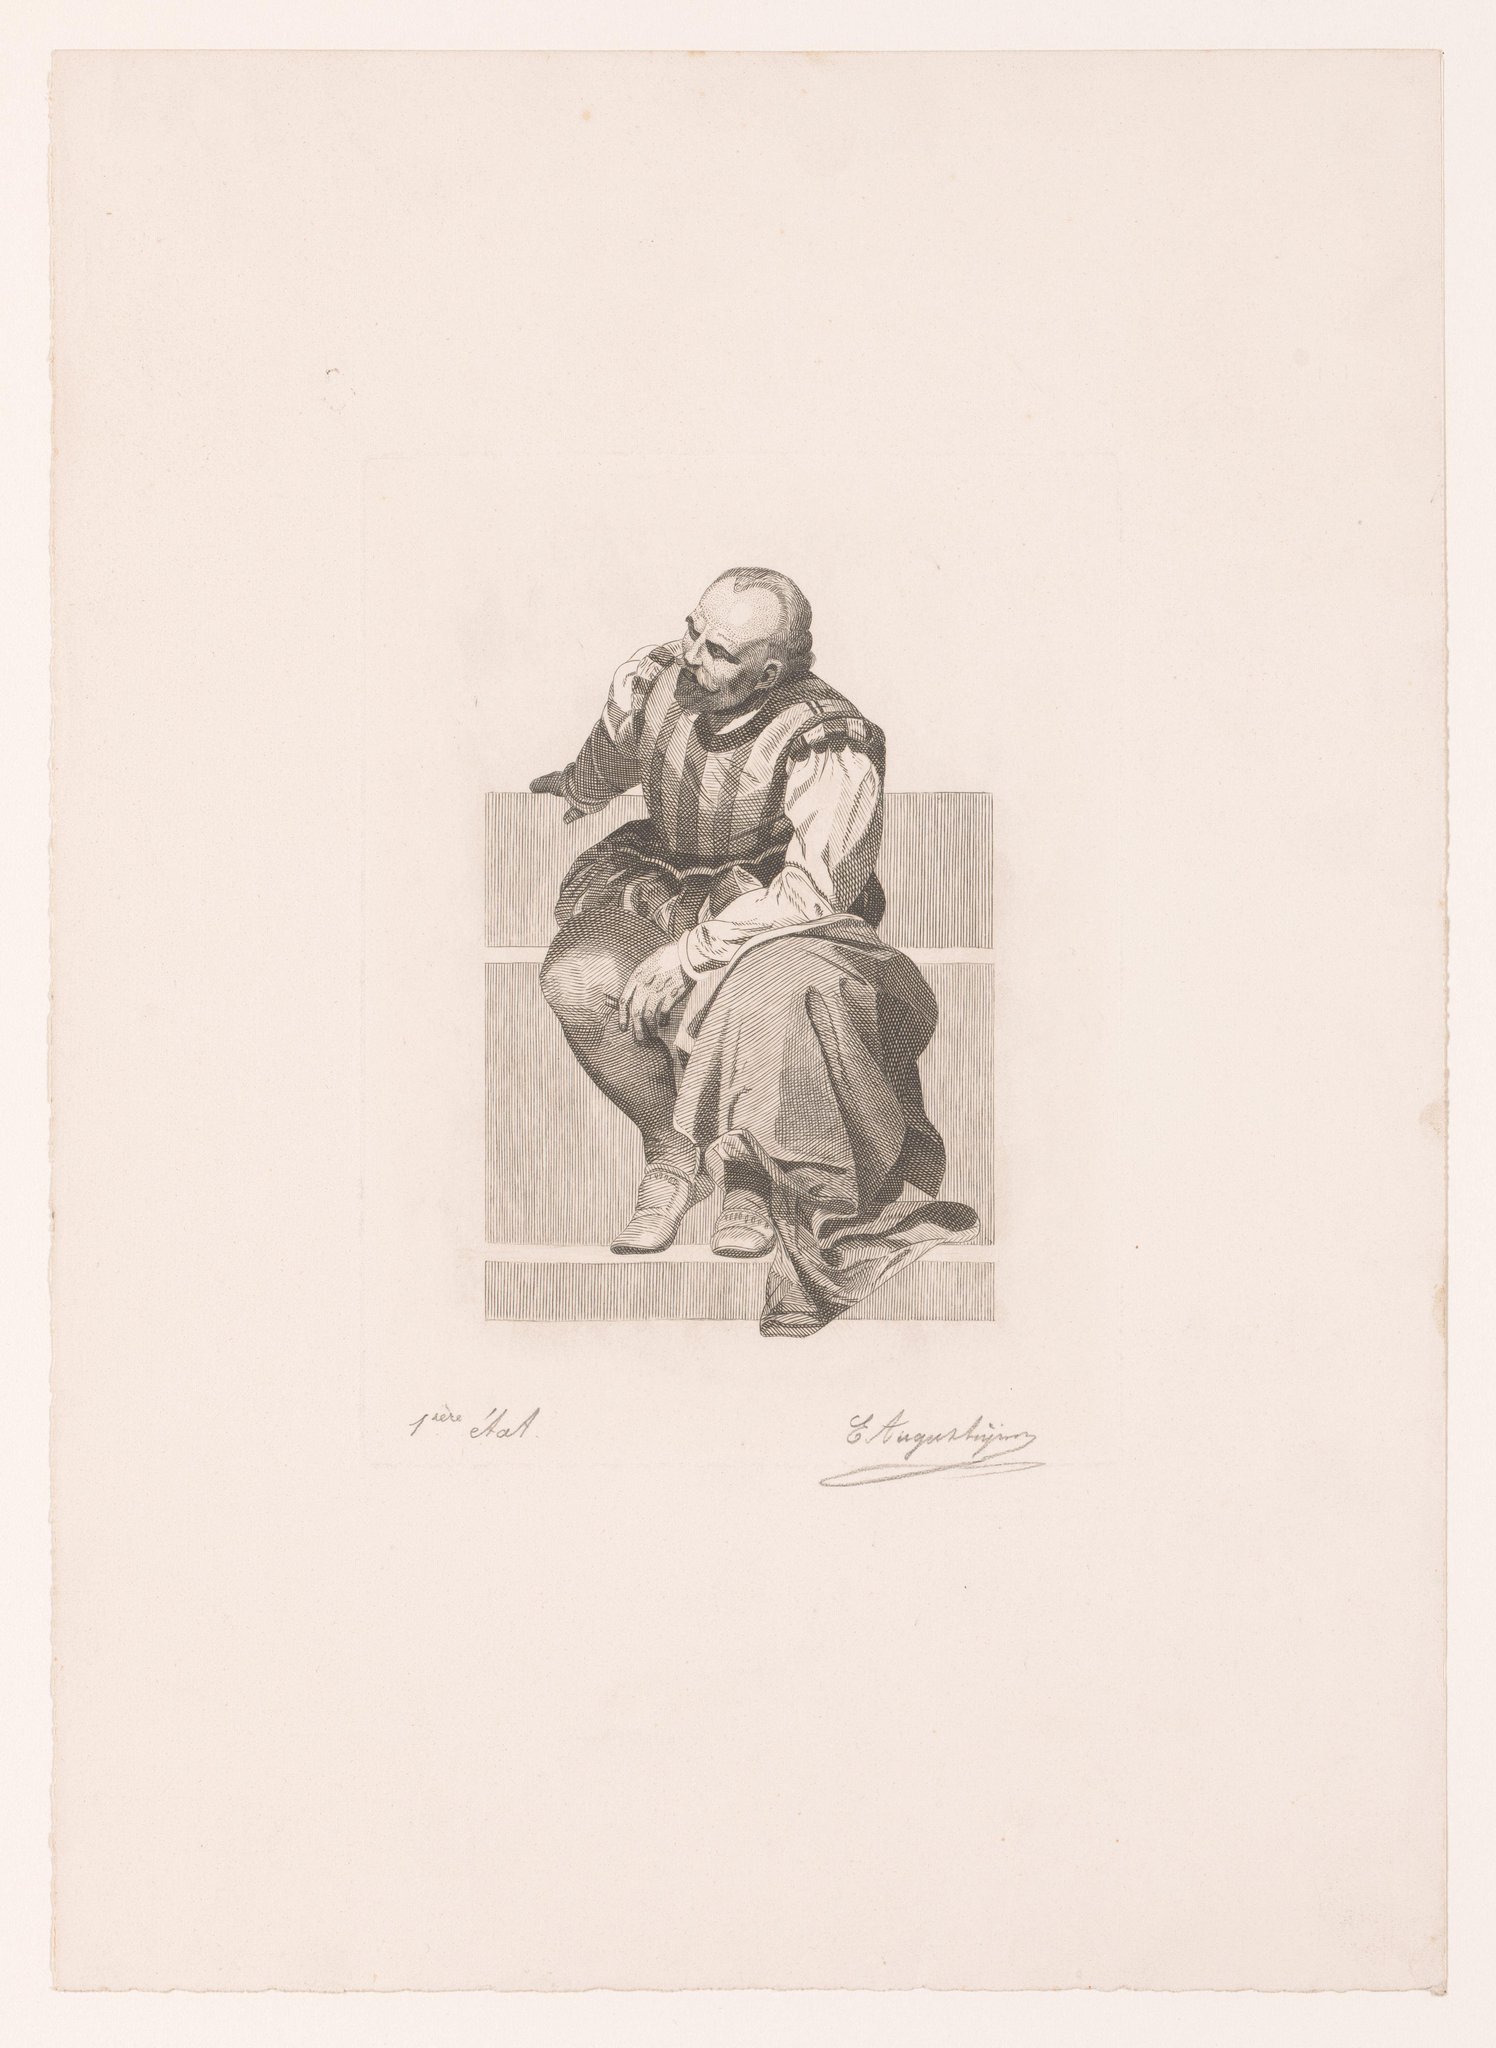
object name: print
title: Zittende man in middeleeuwse kleding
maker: eduard augustyns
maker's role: print maker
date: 1850-1909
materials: paper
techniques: engraving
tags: sitting on an elevation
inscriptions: collector's mark: Lugt 2228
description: Sterfdatum kunstenaar onbekend. Derhalve is voor bepaling van de rechten van dit object de verwervingsdatum aangehouden.